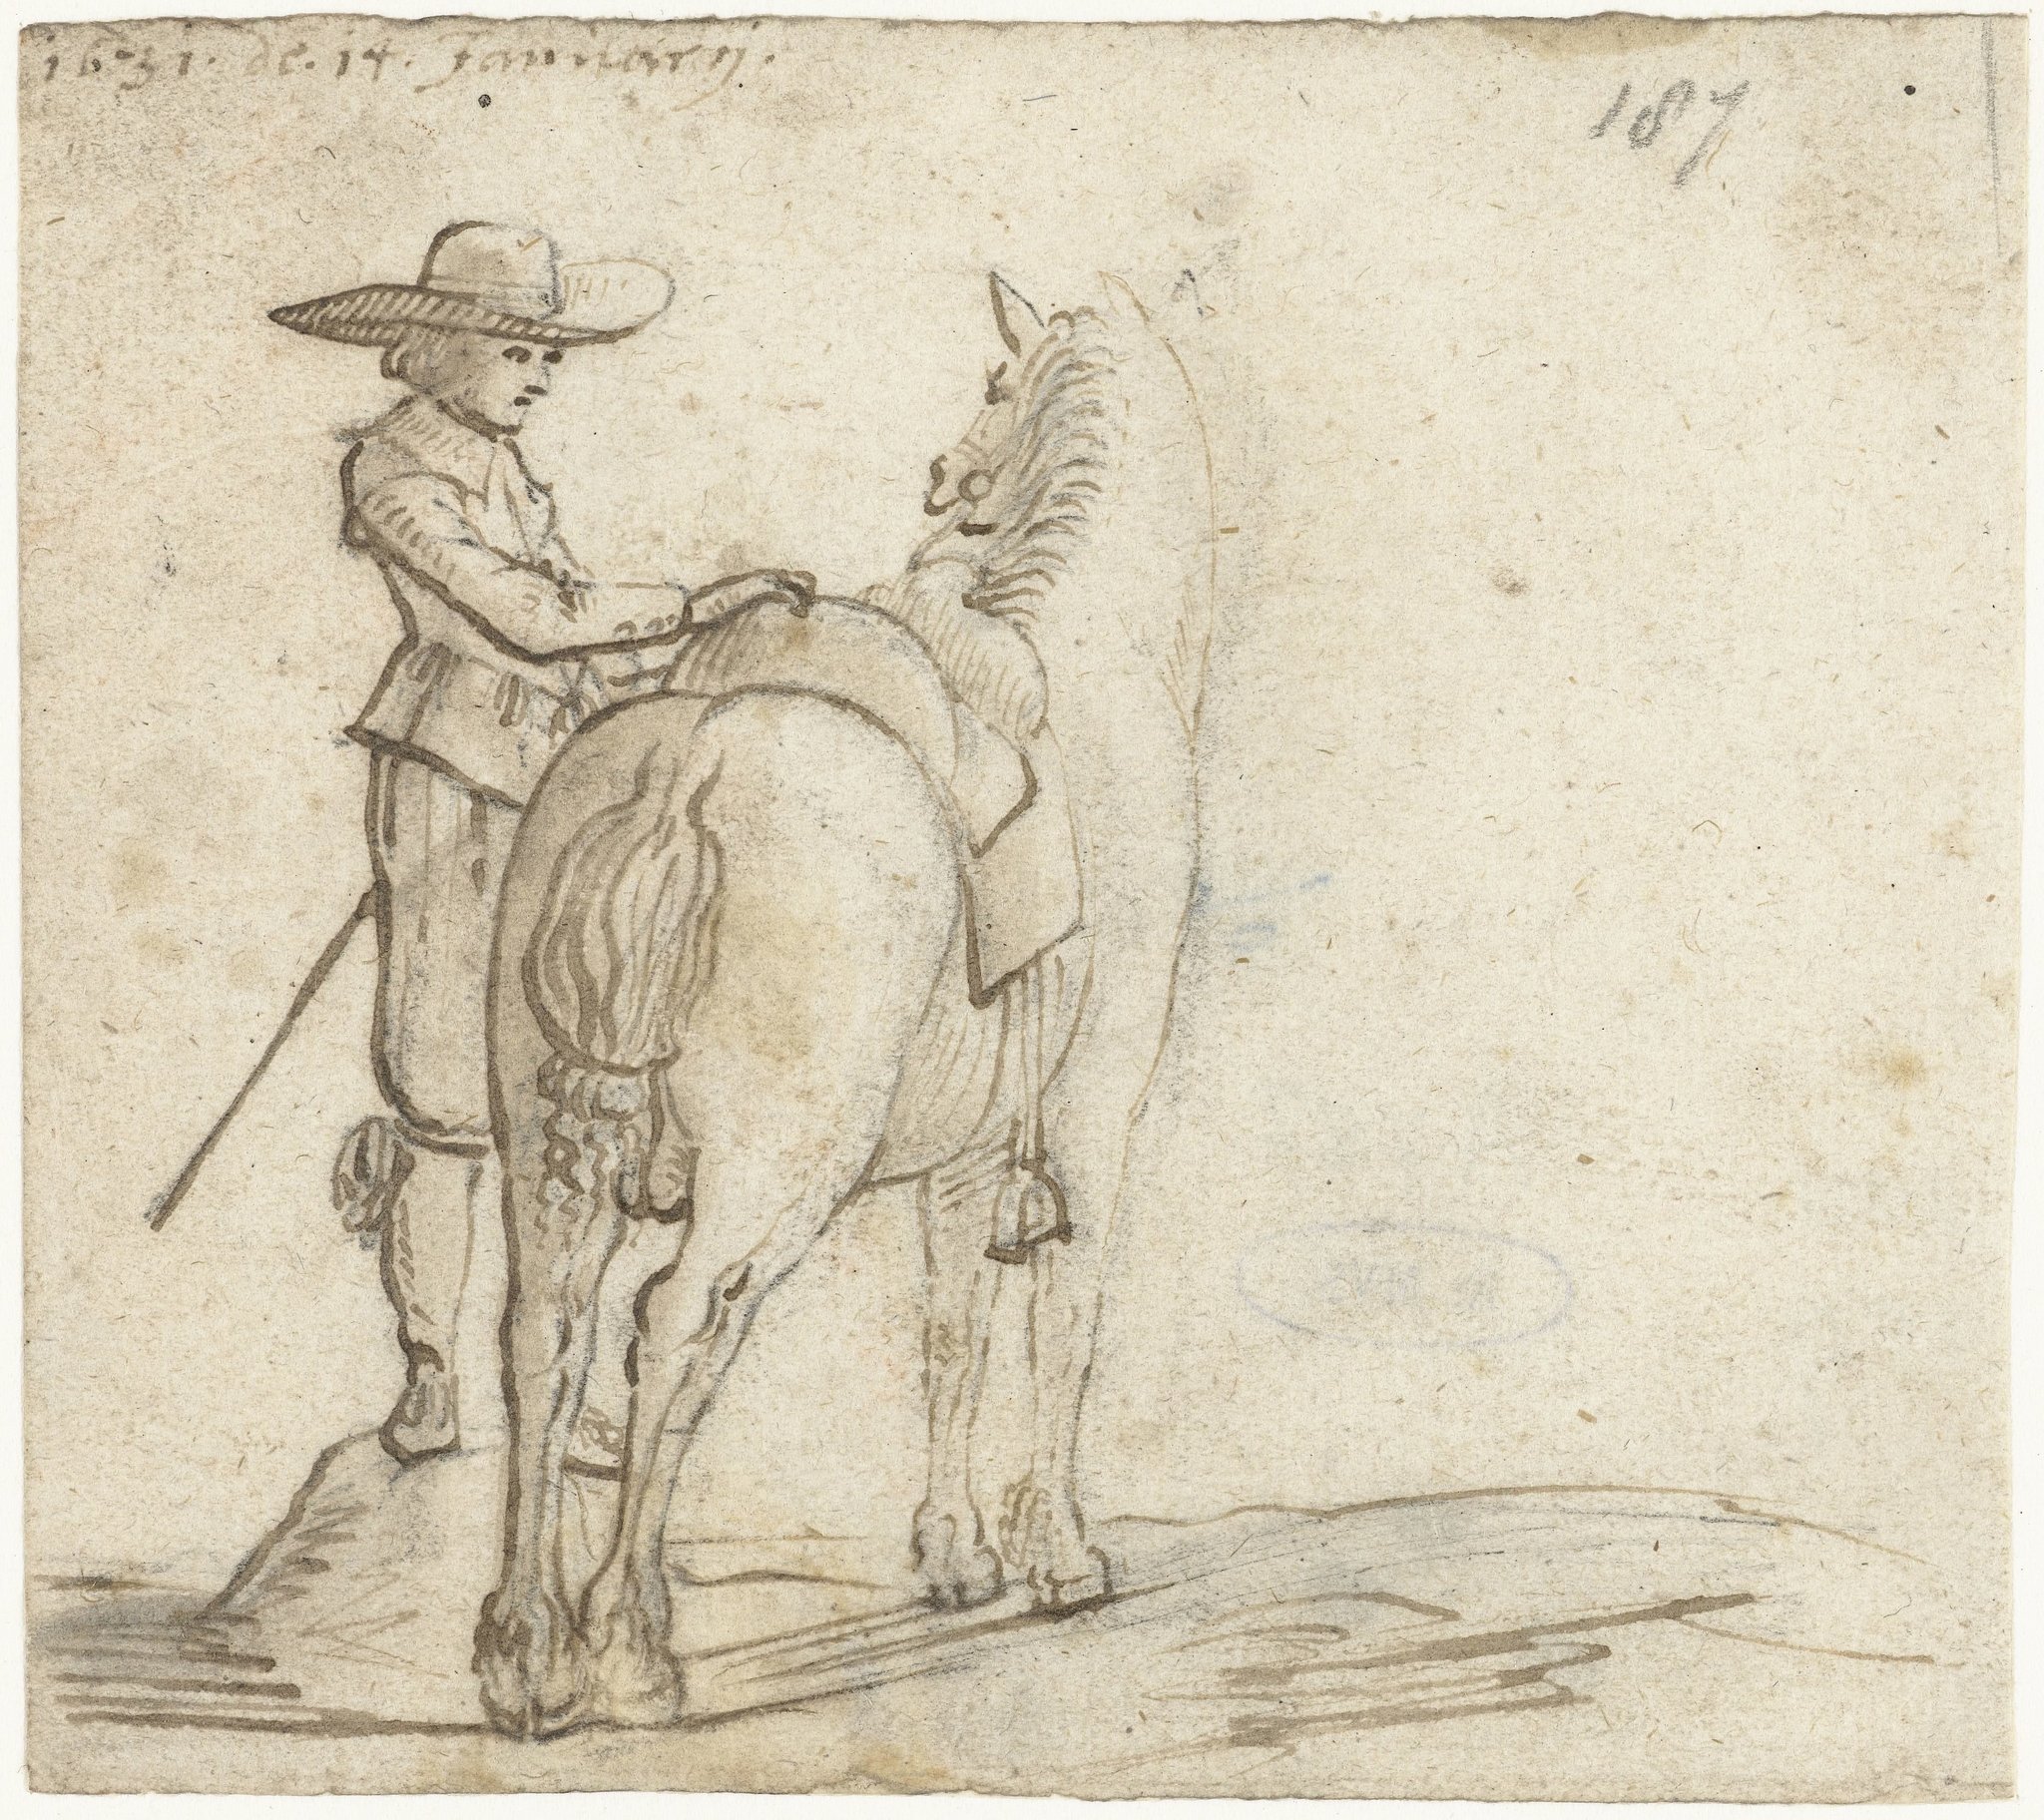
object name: drawing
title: Man die het zadel van een paard verschikt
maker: gerard ter borch (ii)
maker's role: draughtsman, painter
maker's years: 1617-1681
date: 1631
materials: chalk, ink, paper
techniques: brush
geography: zwolle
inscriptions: date: ‘1631. de. 14. Januarij.’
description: Samen met RP-T-1887-A-792 en los papiertje met monogram en datum op een blad bevestigd.